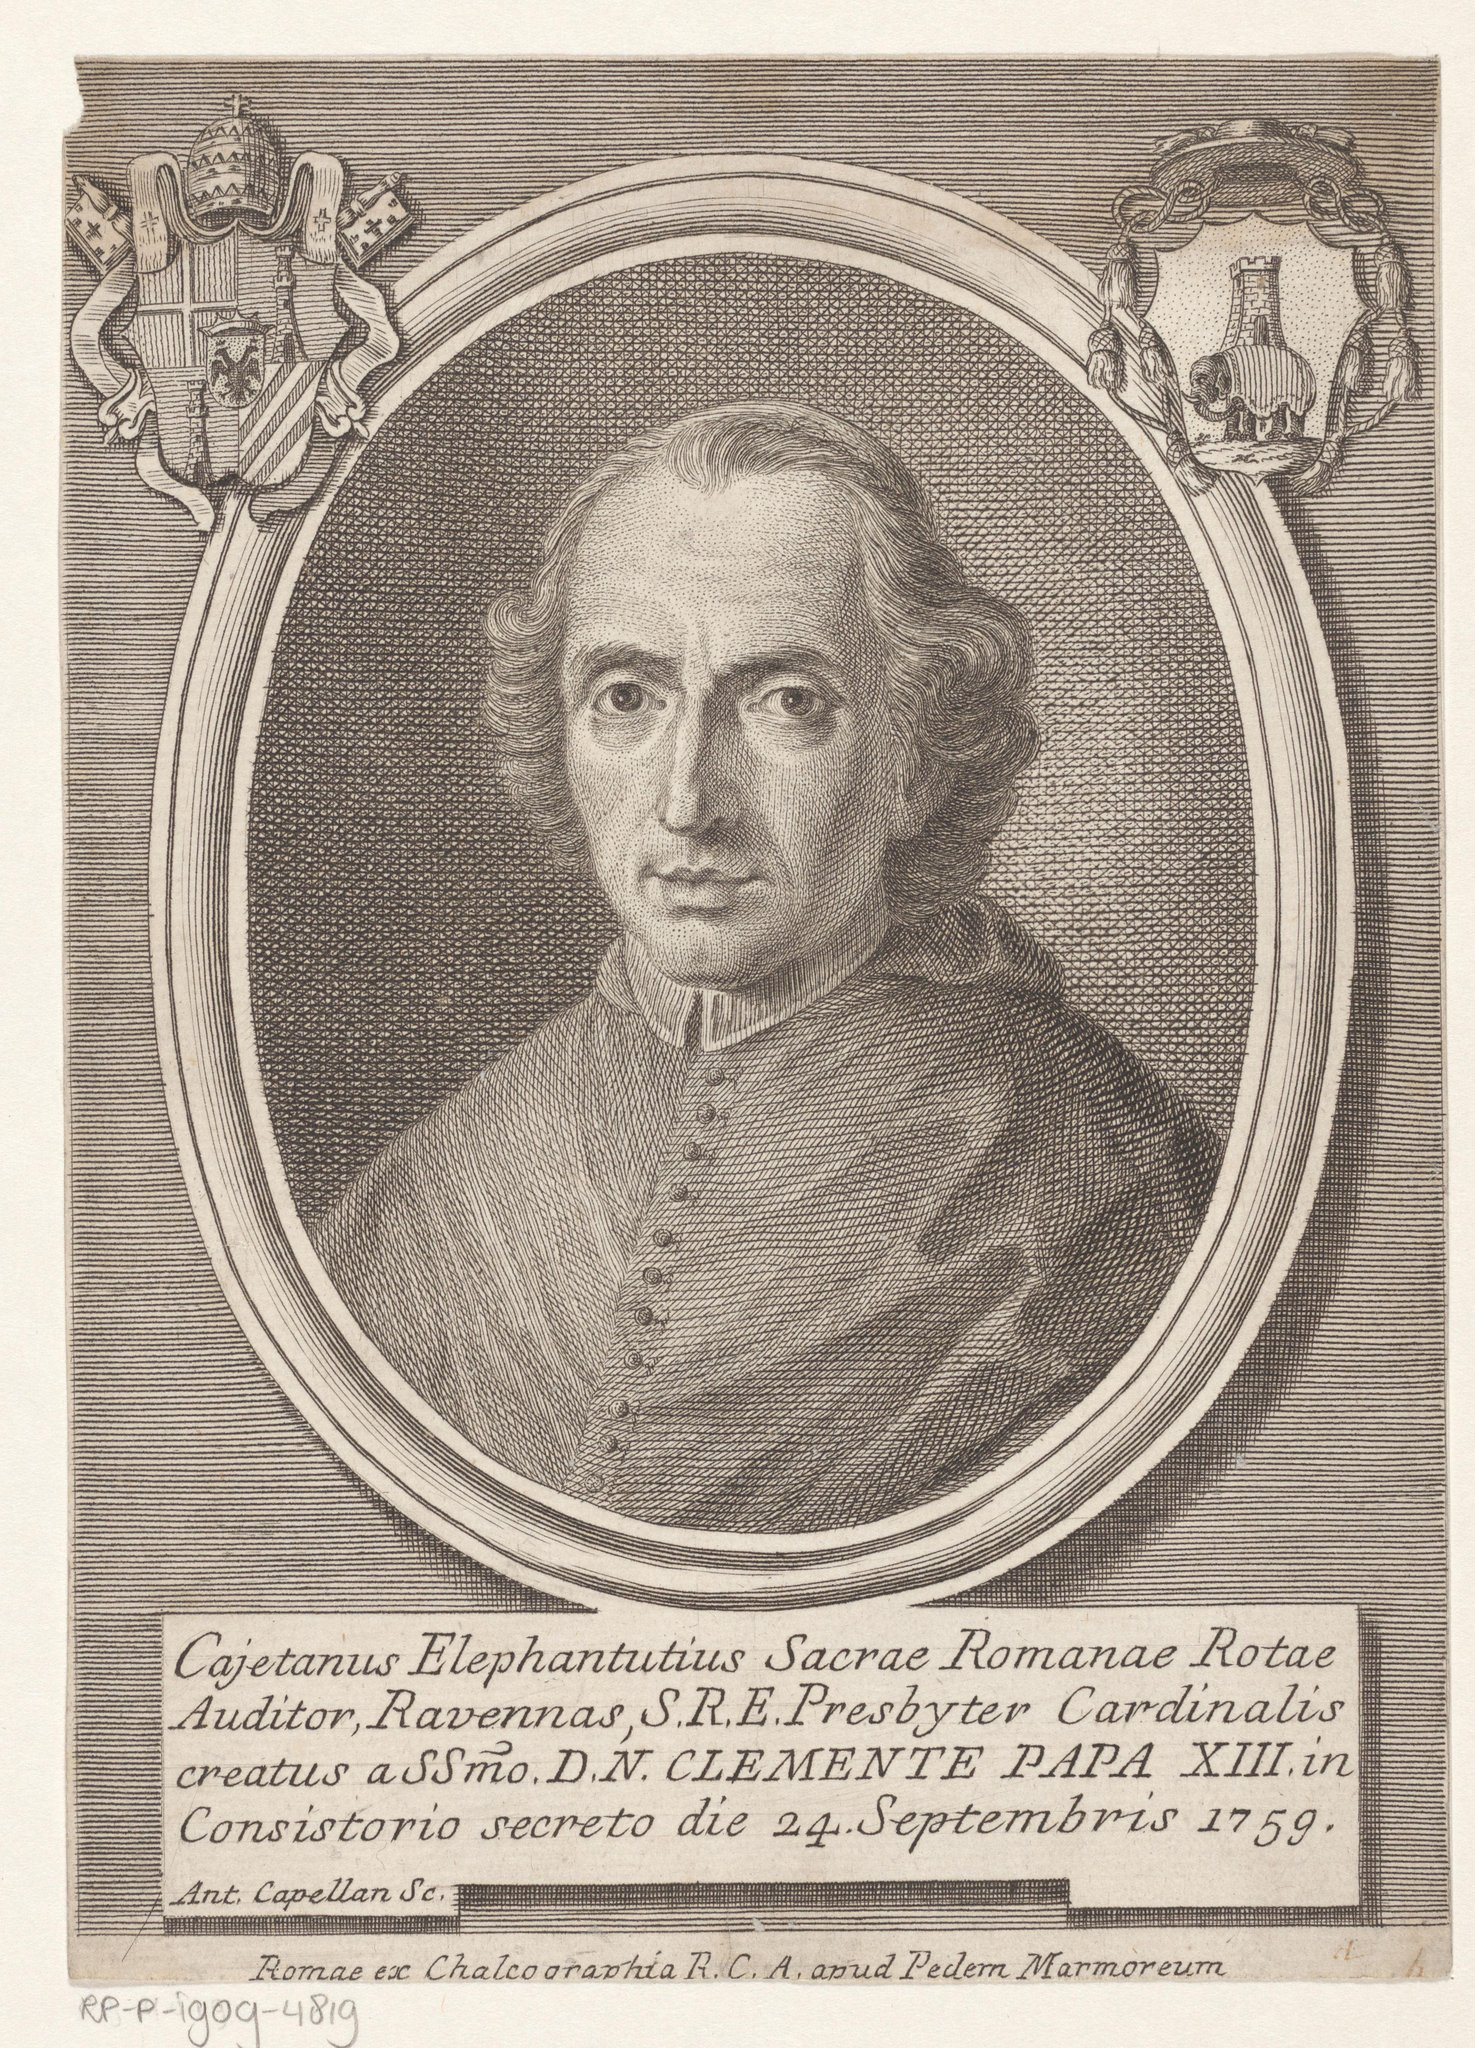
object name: print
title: Portretten van kardinalen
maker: antonio capellan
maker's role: print maker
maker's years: 1735-1788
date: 1759-1788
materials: paper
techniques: etching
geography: italy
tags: cardinal, historical persons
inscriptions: inscription: ‘1759’, collector's mark: Lugt 2228